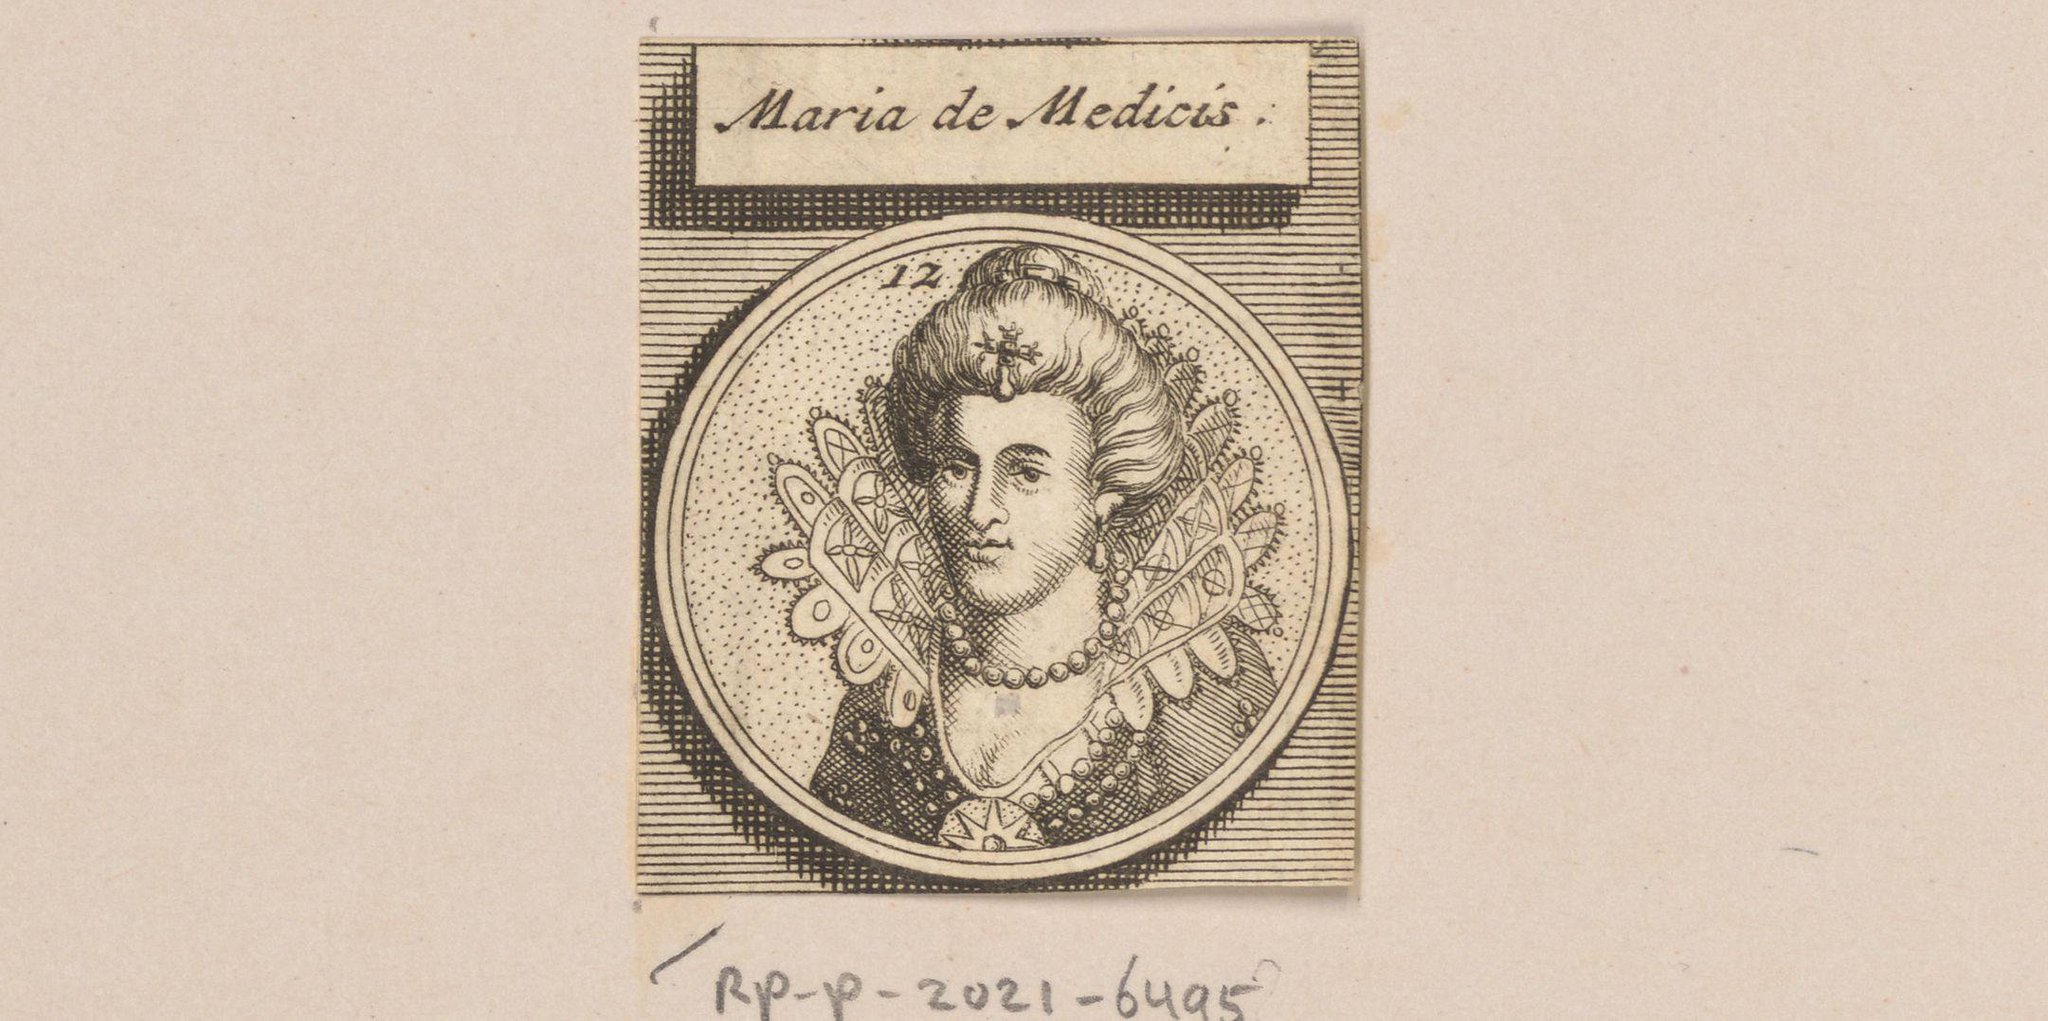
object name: book illustration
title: Portret van Maria de' Medici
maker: Anonymous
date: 1690-1720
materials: paper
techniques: etching, letterpress printing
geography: northern netherlands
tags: print maker, maria de' medici, historical persons - bb - woman, ornament ~ medallion, queen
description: Prent komt uit een onbekende publicatie, mogelijk een deel van Johann Ludwig Gottfrieds 'Historische Kronyck'.